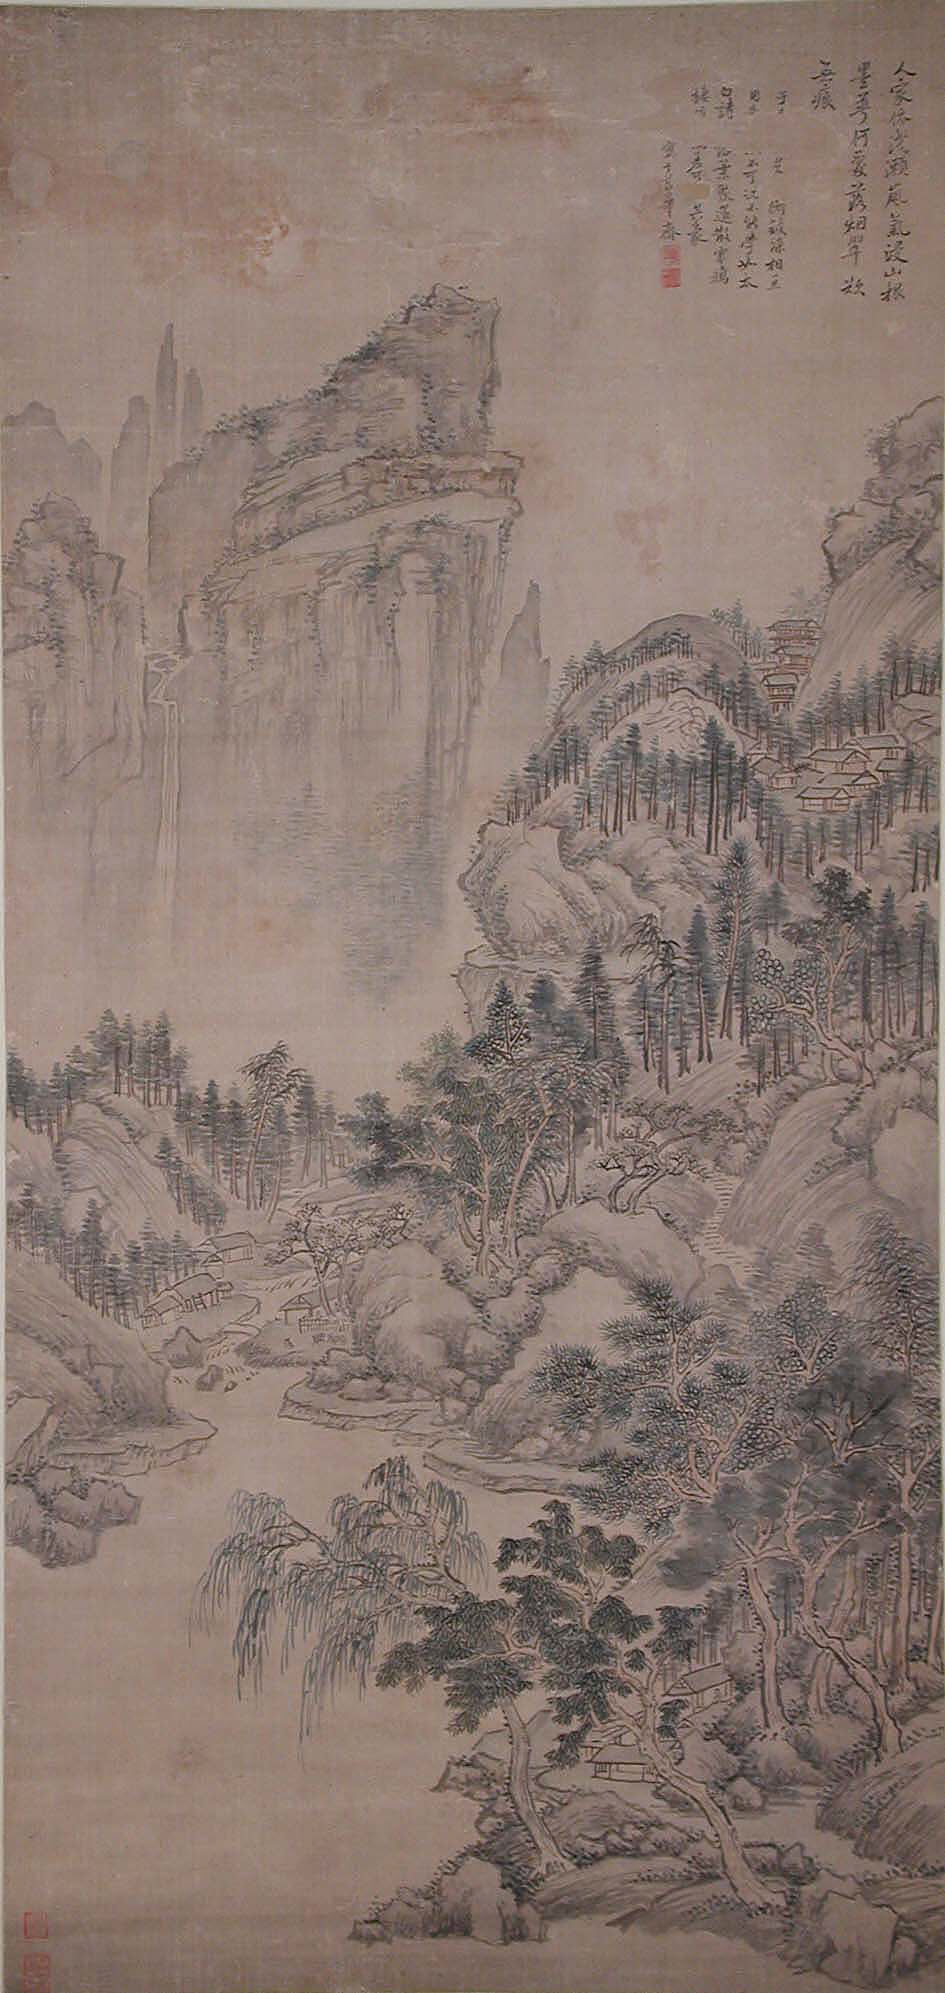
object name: hanging scroll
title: Landscape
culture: chinese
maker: yun shouping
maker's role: artist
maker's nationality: chinese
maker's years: 1633-1690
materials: ink, silk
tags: mountains,landscapes